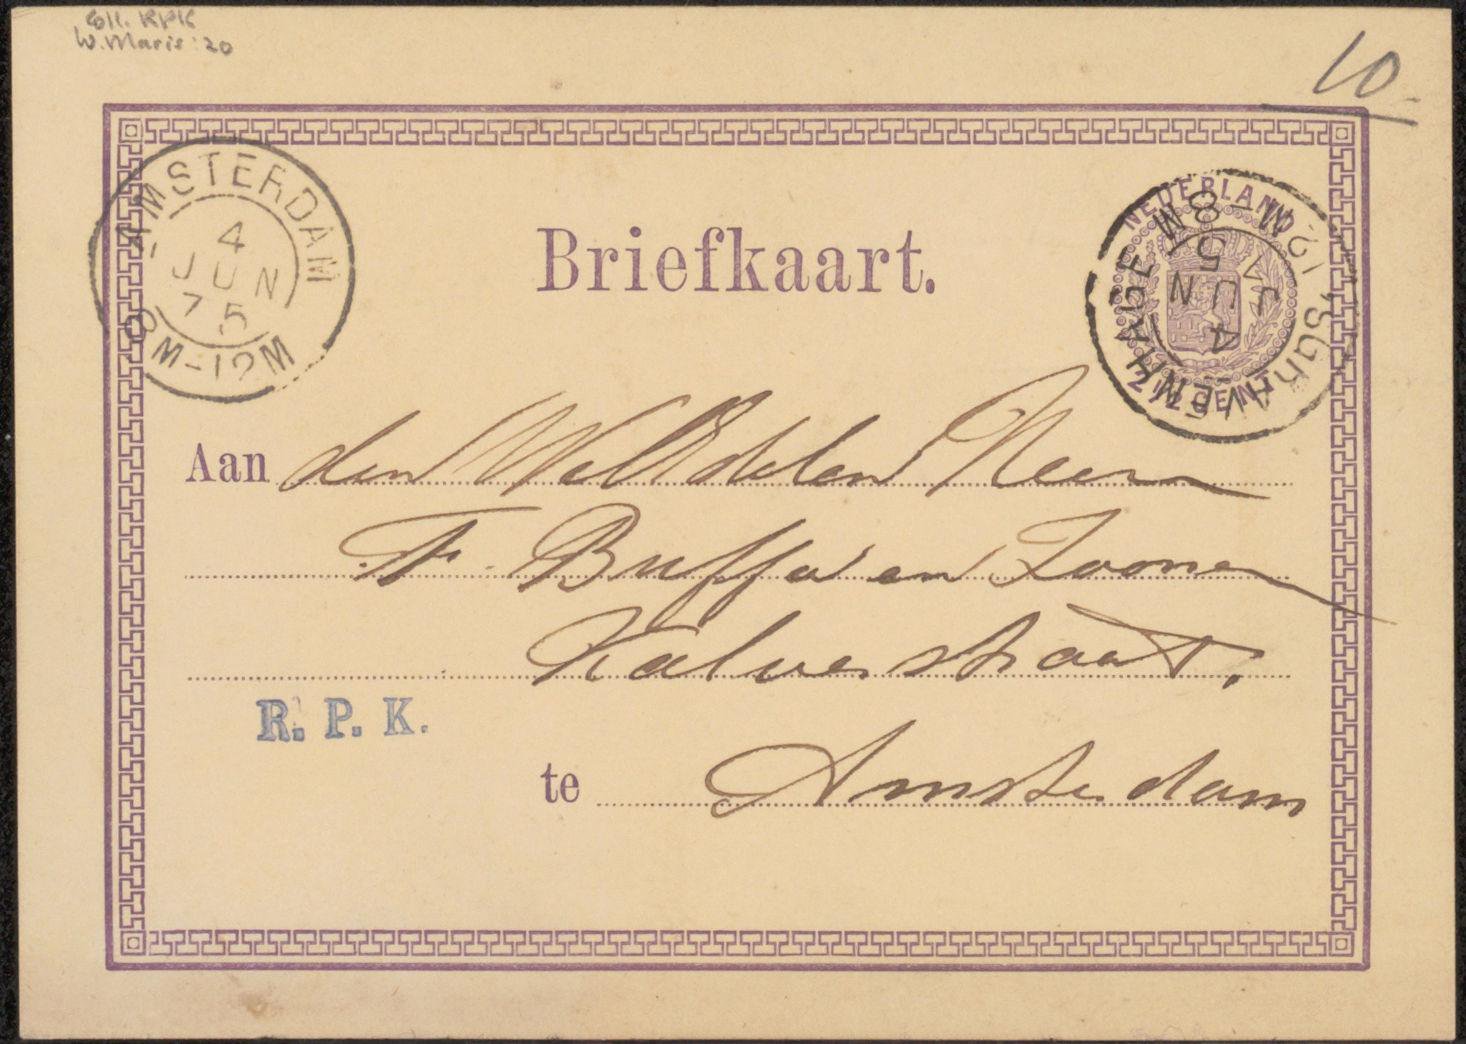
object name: postcard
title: Briefkaart aan Frans Buffa en Zonen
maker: willem maris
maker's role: draughtsman, painter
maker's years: 1844-1910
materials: cardboard, ink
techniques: pen, writing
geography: the hague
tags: publisher, family life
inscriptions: collector's mark: Lugt 2228, collector's mark: Lugt 2233